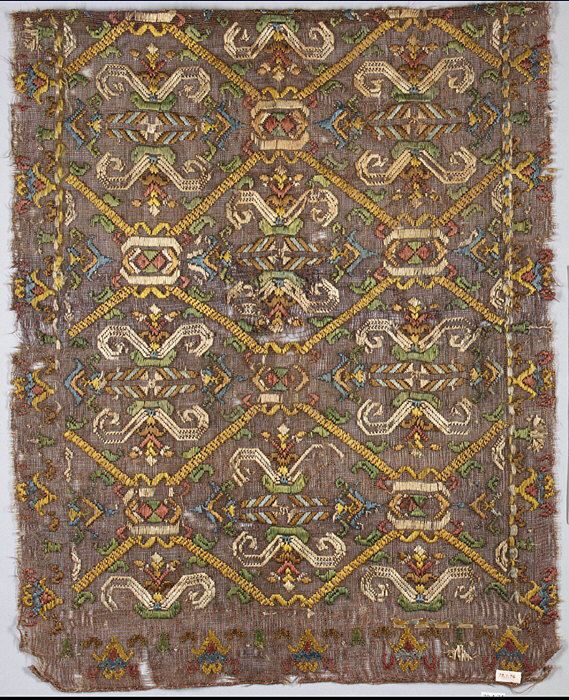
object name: square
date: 1550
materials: silk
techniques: embroidery